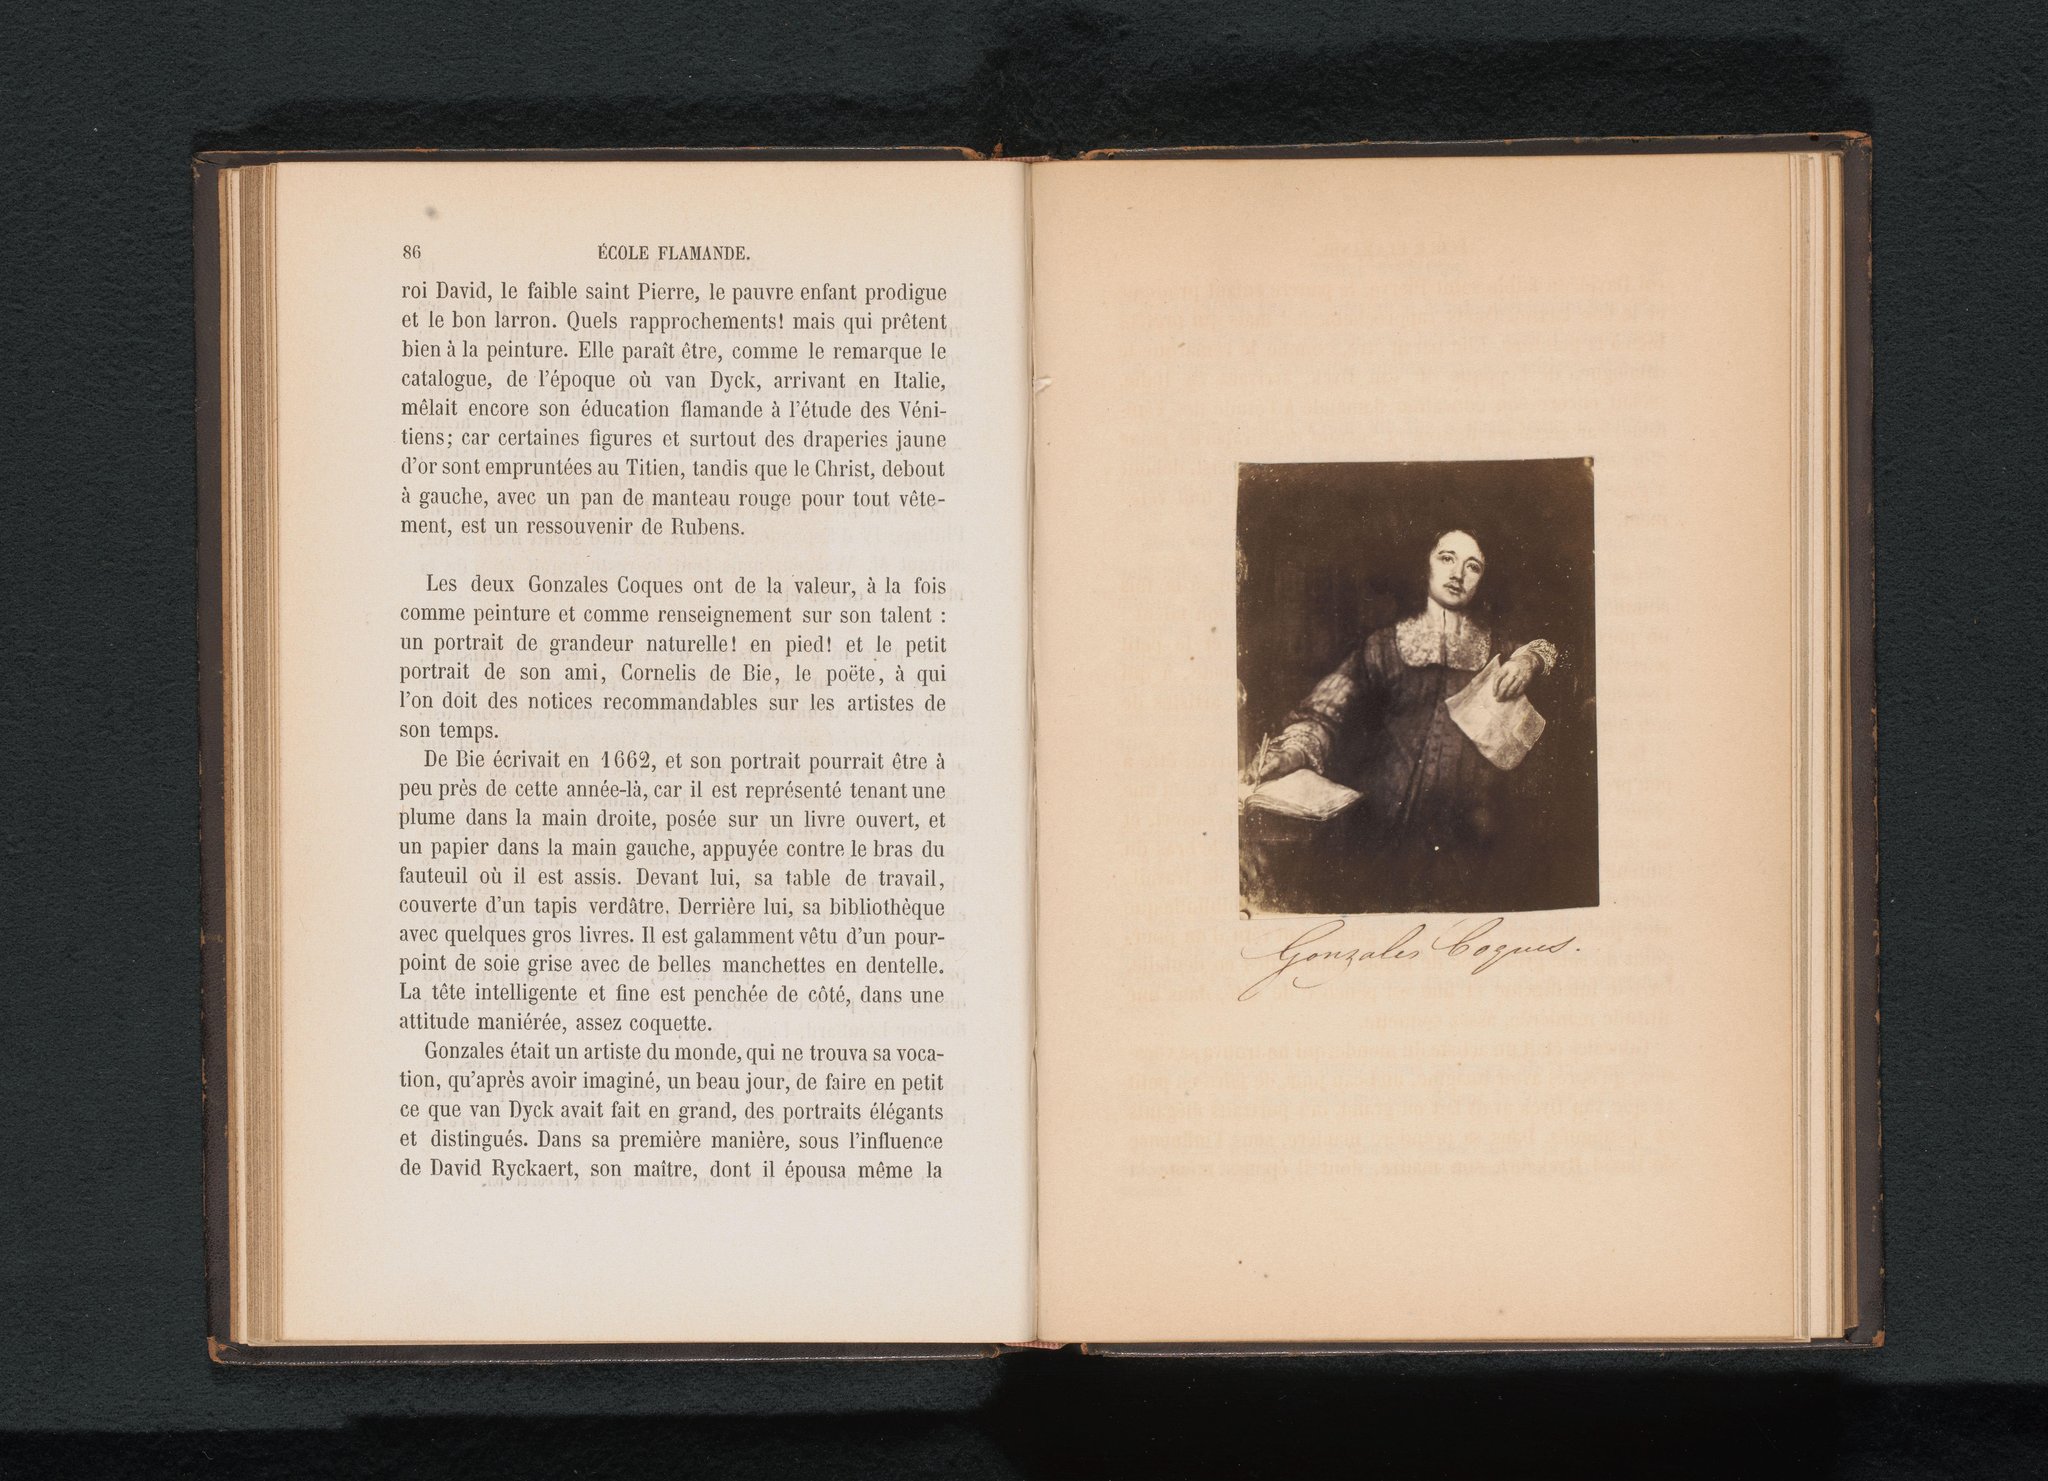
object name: page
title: Fotoreproductie van een schilderij van een zelfportret door Gonzales Coques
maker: edmond fierlants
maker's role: fotograaf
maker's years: 1819-1869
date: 1855-1860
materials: photographic support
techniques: albumen print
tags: antwerp, painter, draughtsman, gonzales coques, historical persons, portrait, self-portrait of painter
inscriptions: name: ‘Gonzales Coques.’